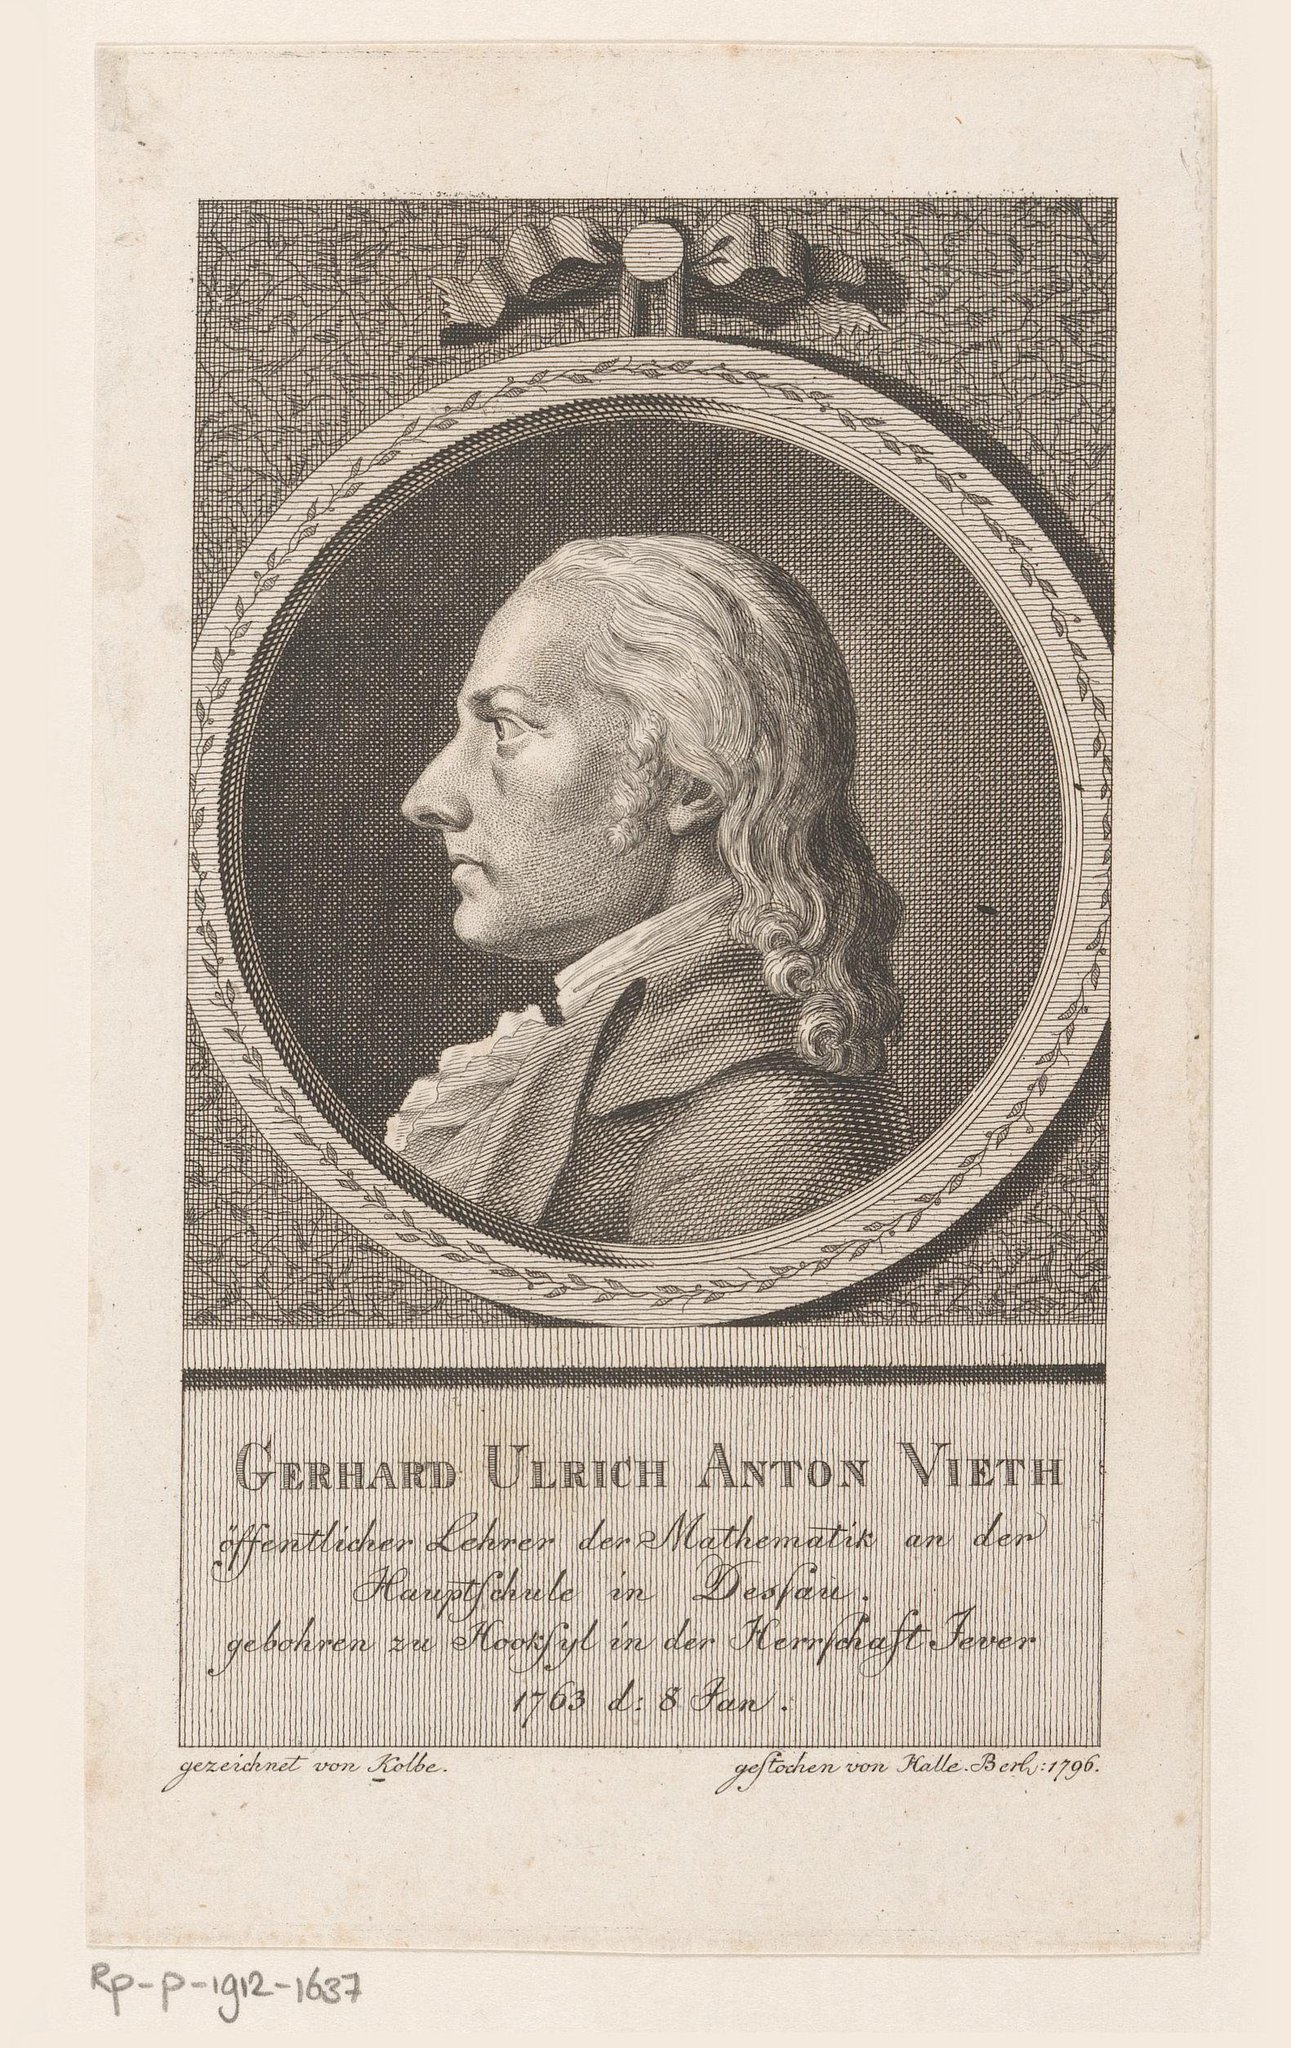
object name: print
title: Portret van Gebhard Ulrich Anton Vieth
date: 1796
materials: paper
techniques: engraving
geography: berlin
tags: ornament ~ medallion, historical persons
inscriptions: collector's mark: Lugt 2228